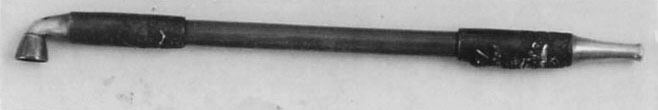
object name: tobacco pipe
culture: japanese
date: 1801-1900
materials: iron